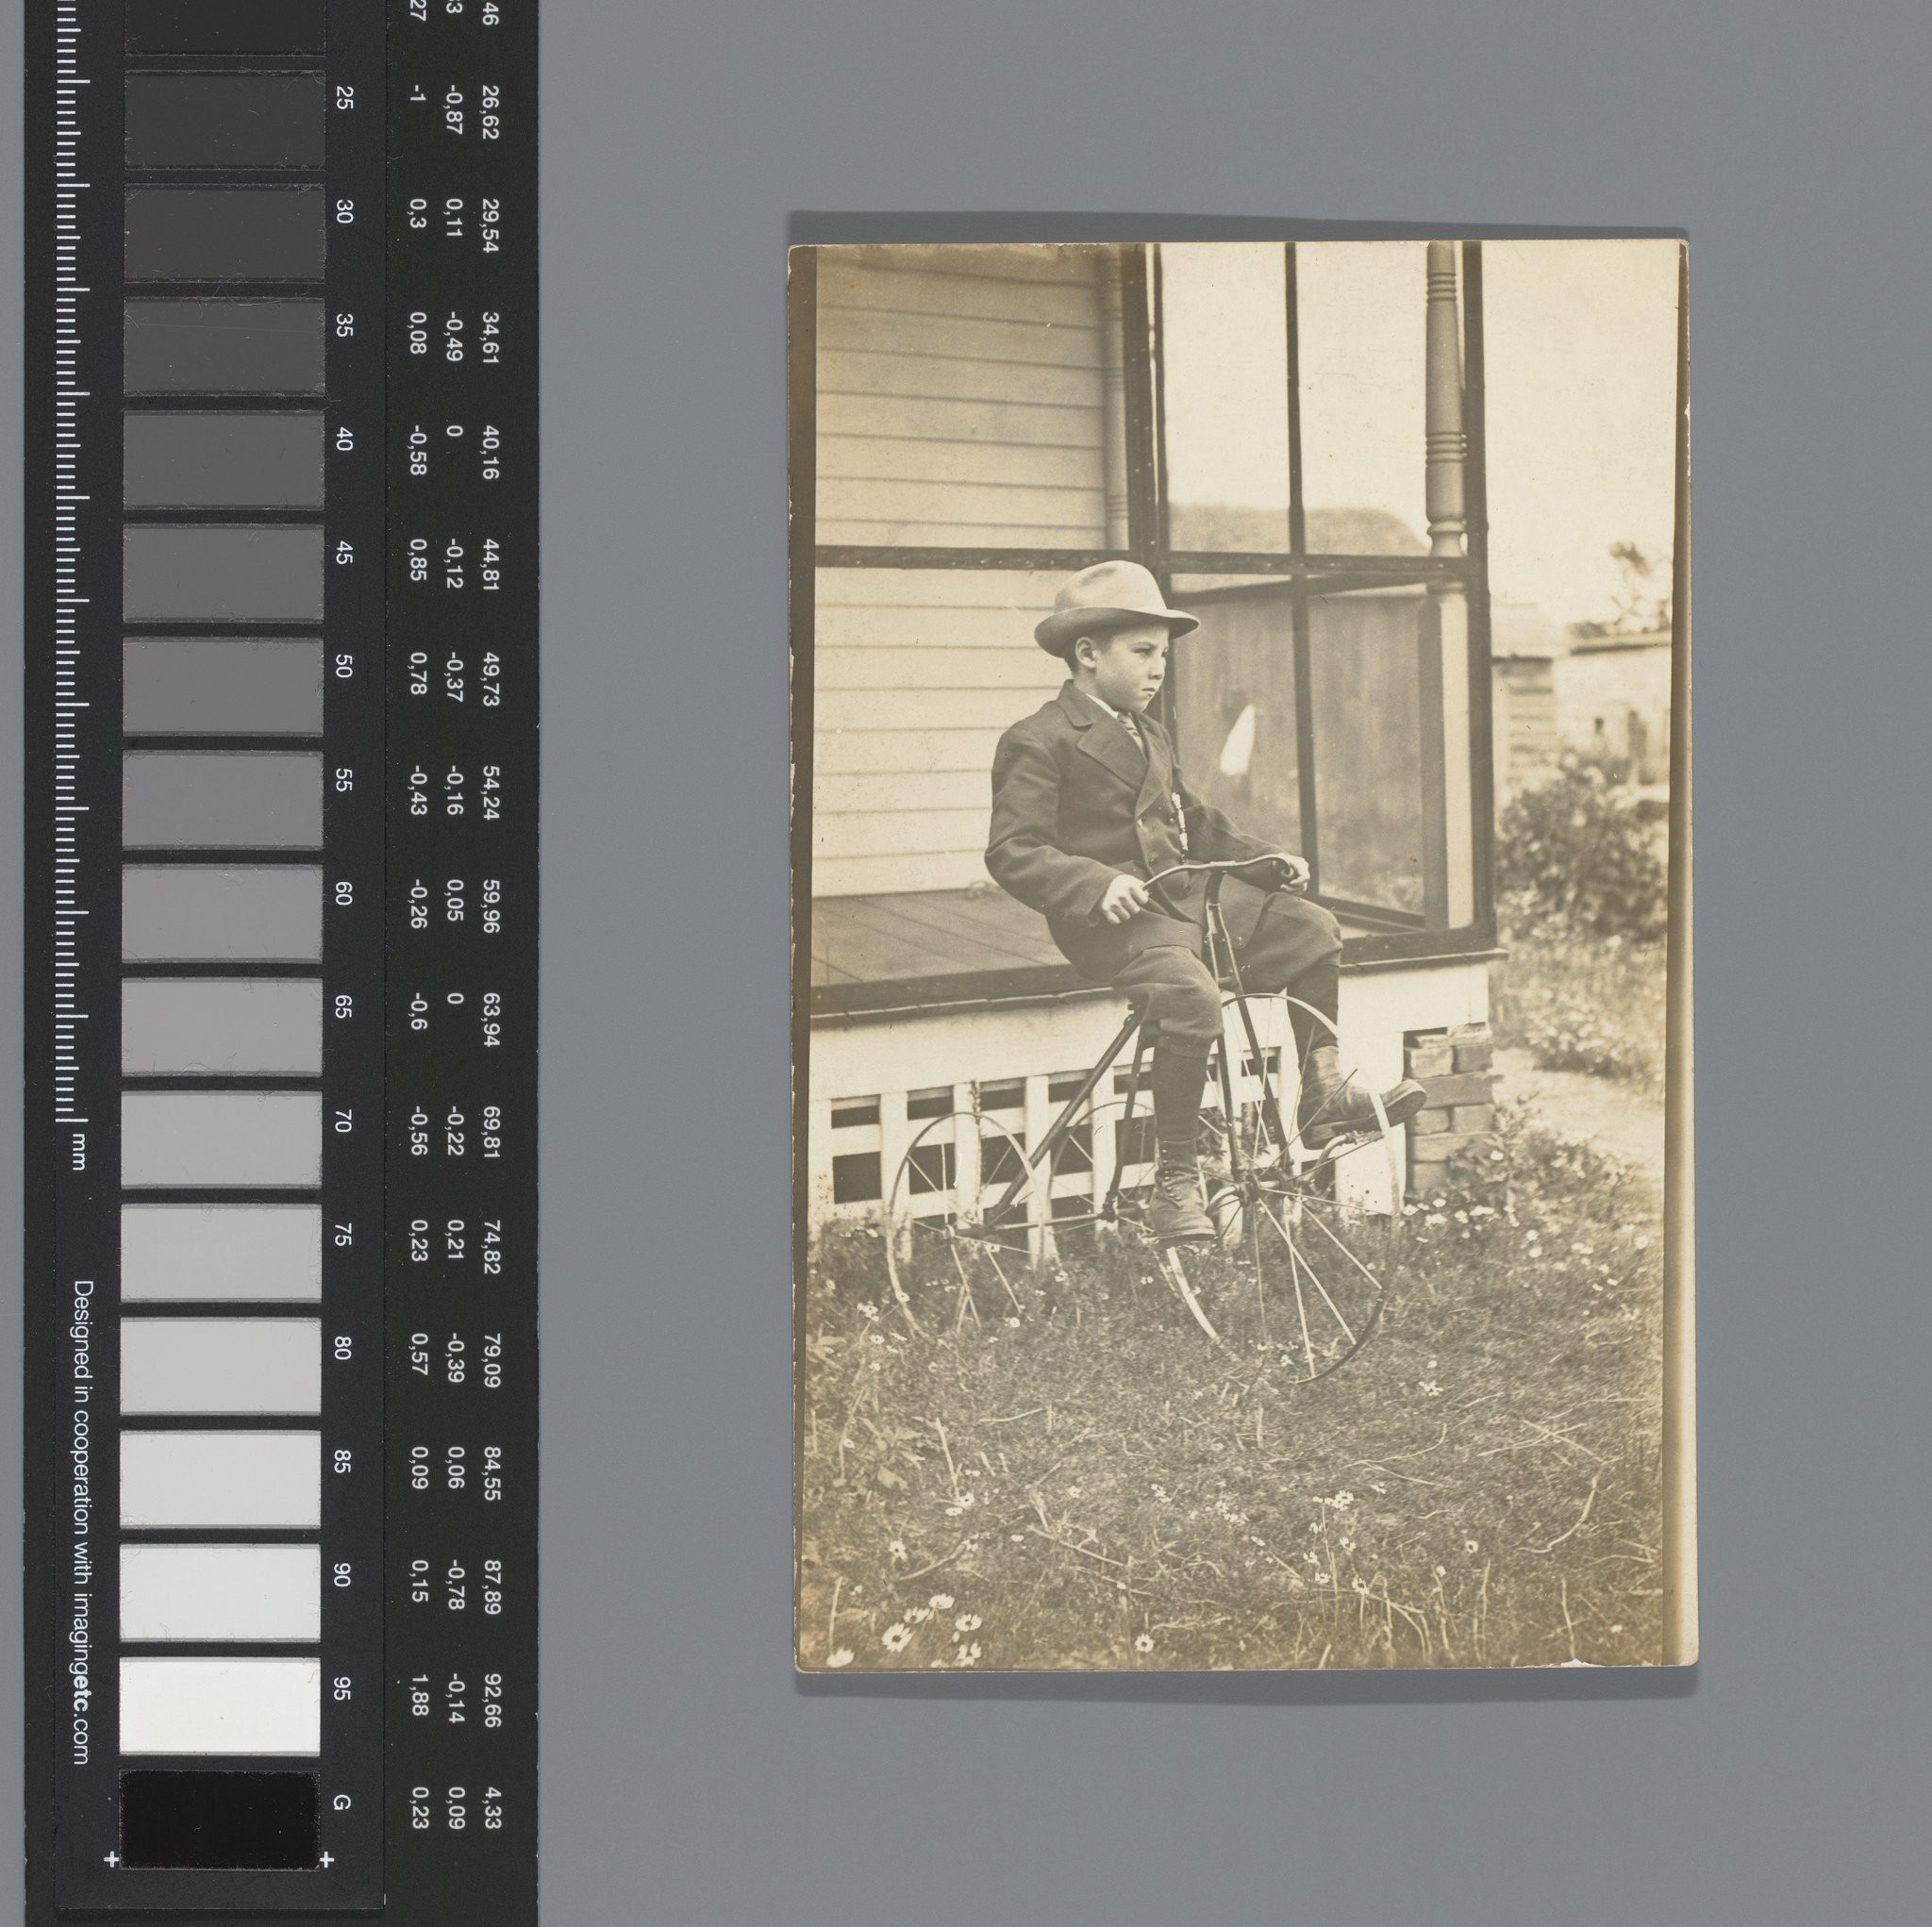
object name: ansichtkaart, prentbriefkaart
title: Jongen op een driewieler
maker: Anonymous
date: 1907-1930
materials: photographic support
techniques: gelatin silver print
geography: united states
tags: united states of america